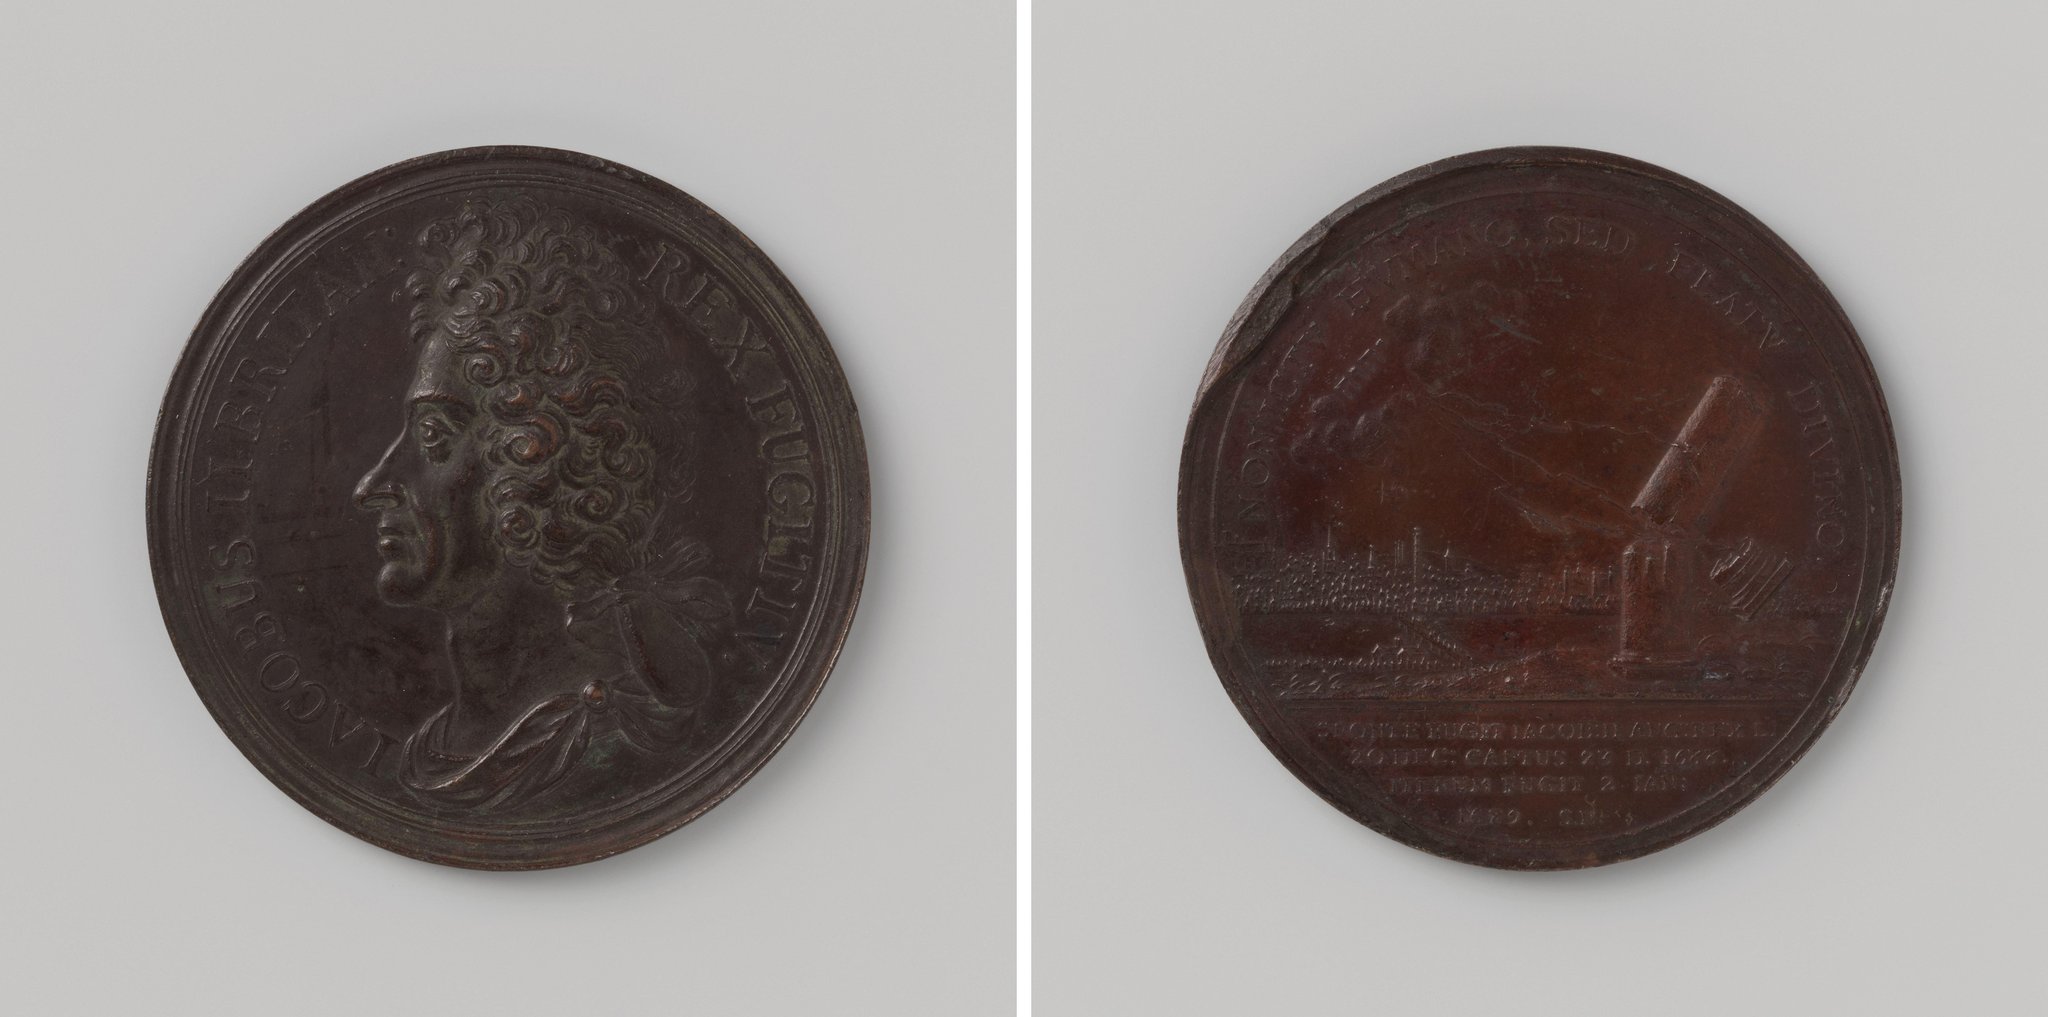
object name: history medal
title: Vlucht van Jacobus II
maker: jan smeltzing (i)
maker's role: modelleur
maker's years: 1656-1693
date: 1689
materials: bronze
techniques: striking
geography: leiden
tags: jacobus ii (koning van engeland en schotland), london